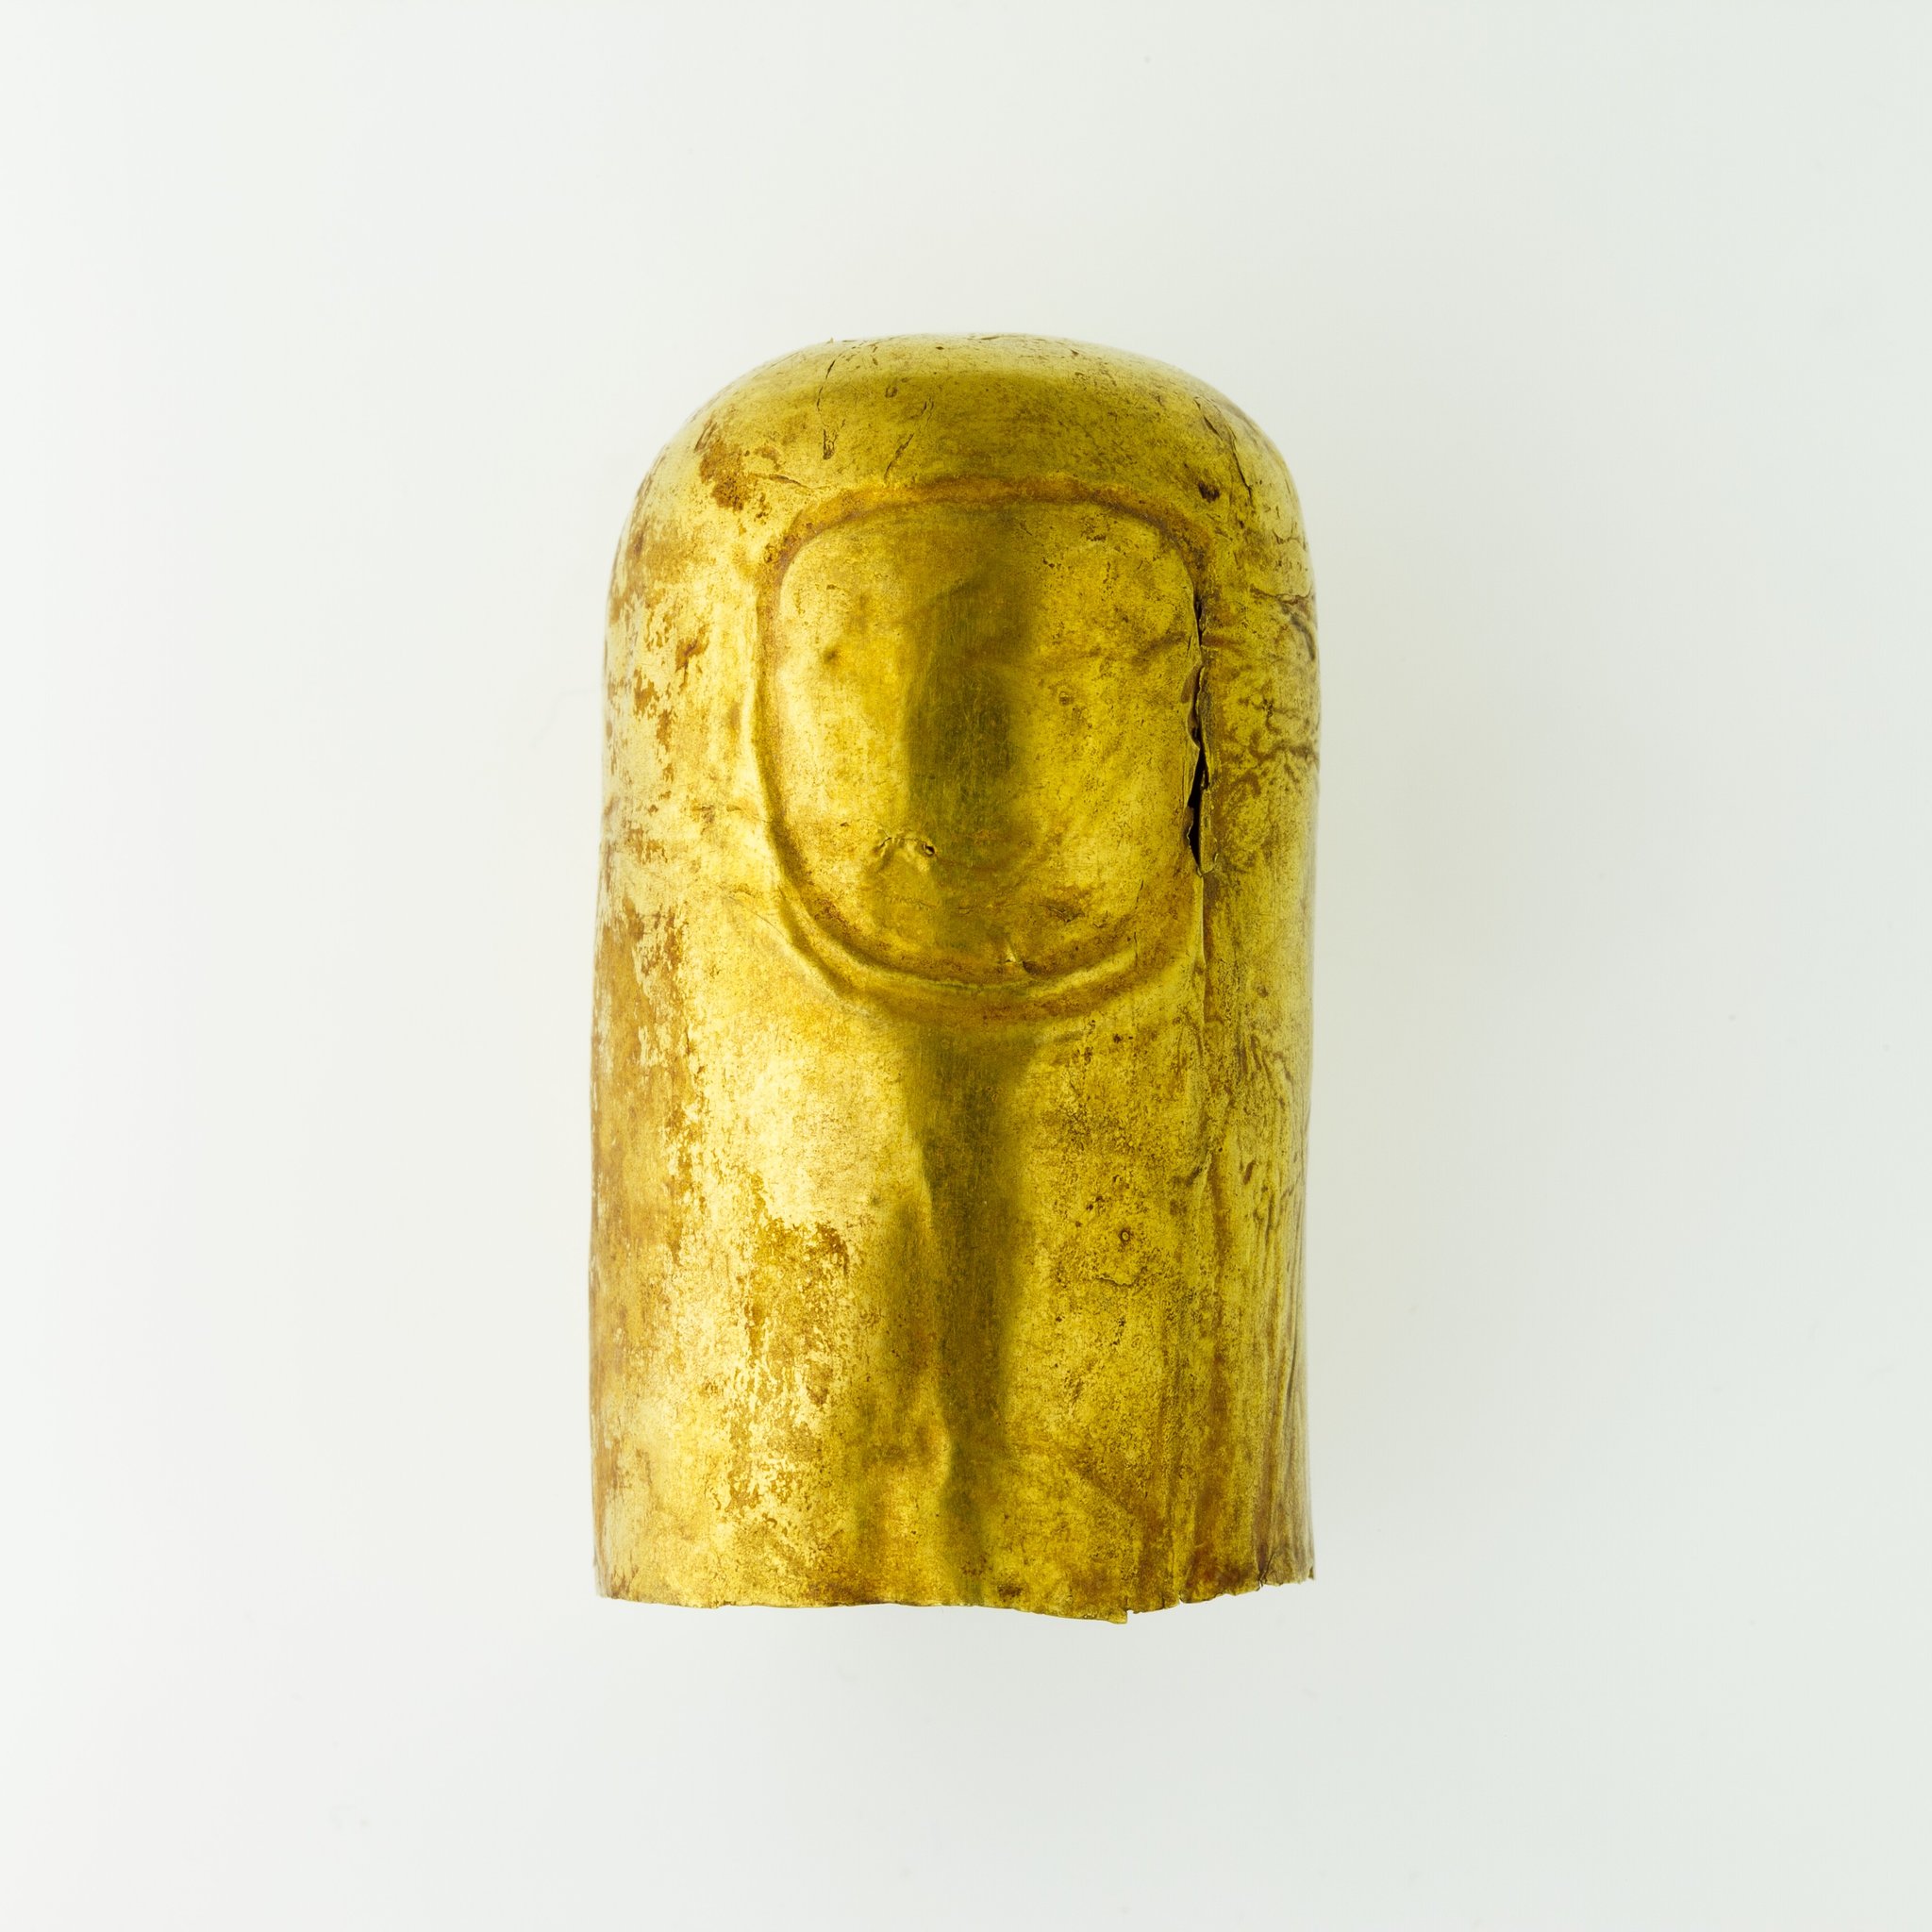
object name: toe stall, group 1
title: Toe stall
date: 1479-1425 BCE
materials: gold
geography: egypt